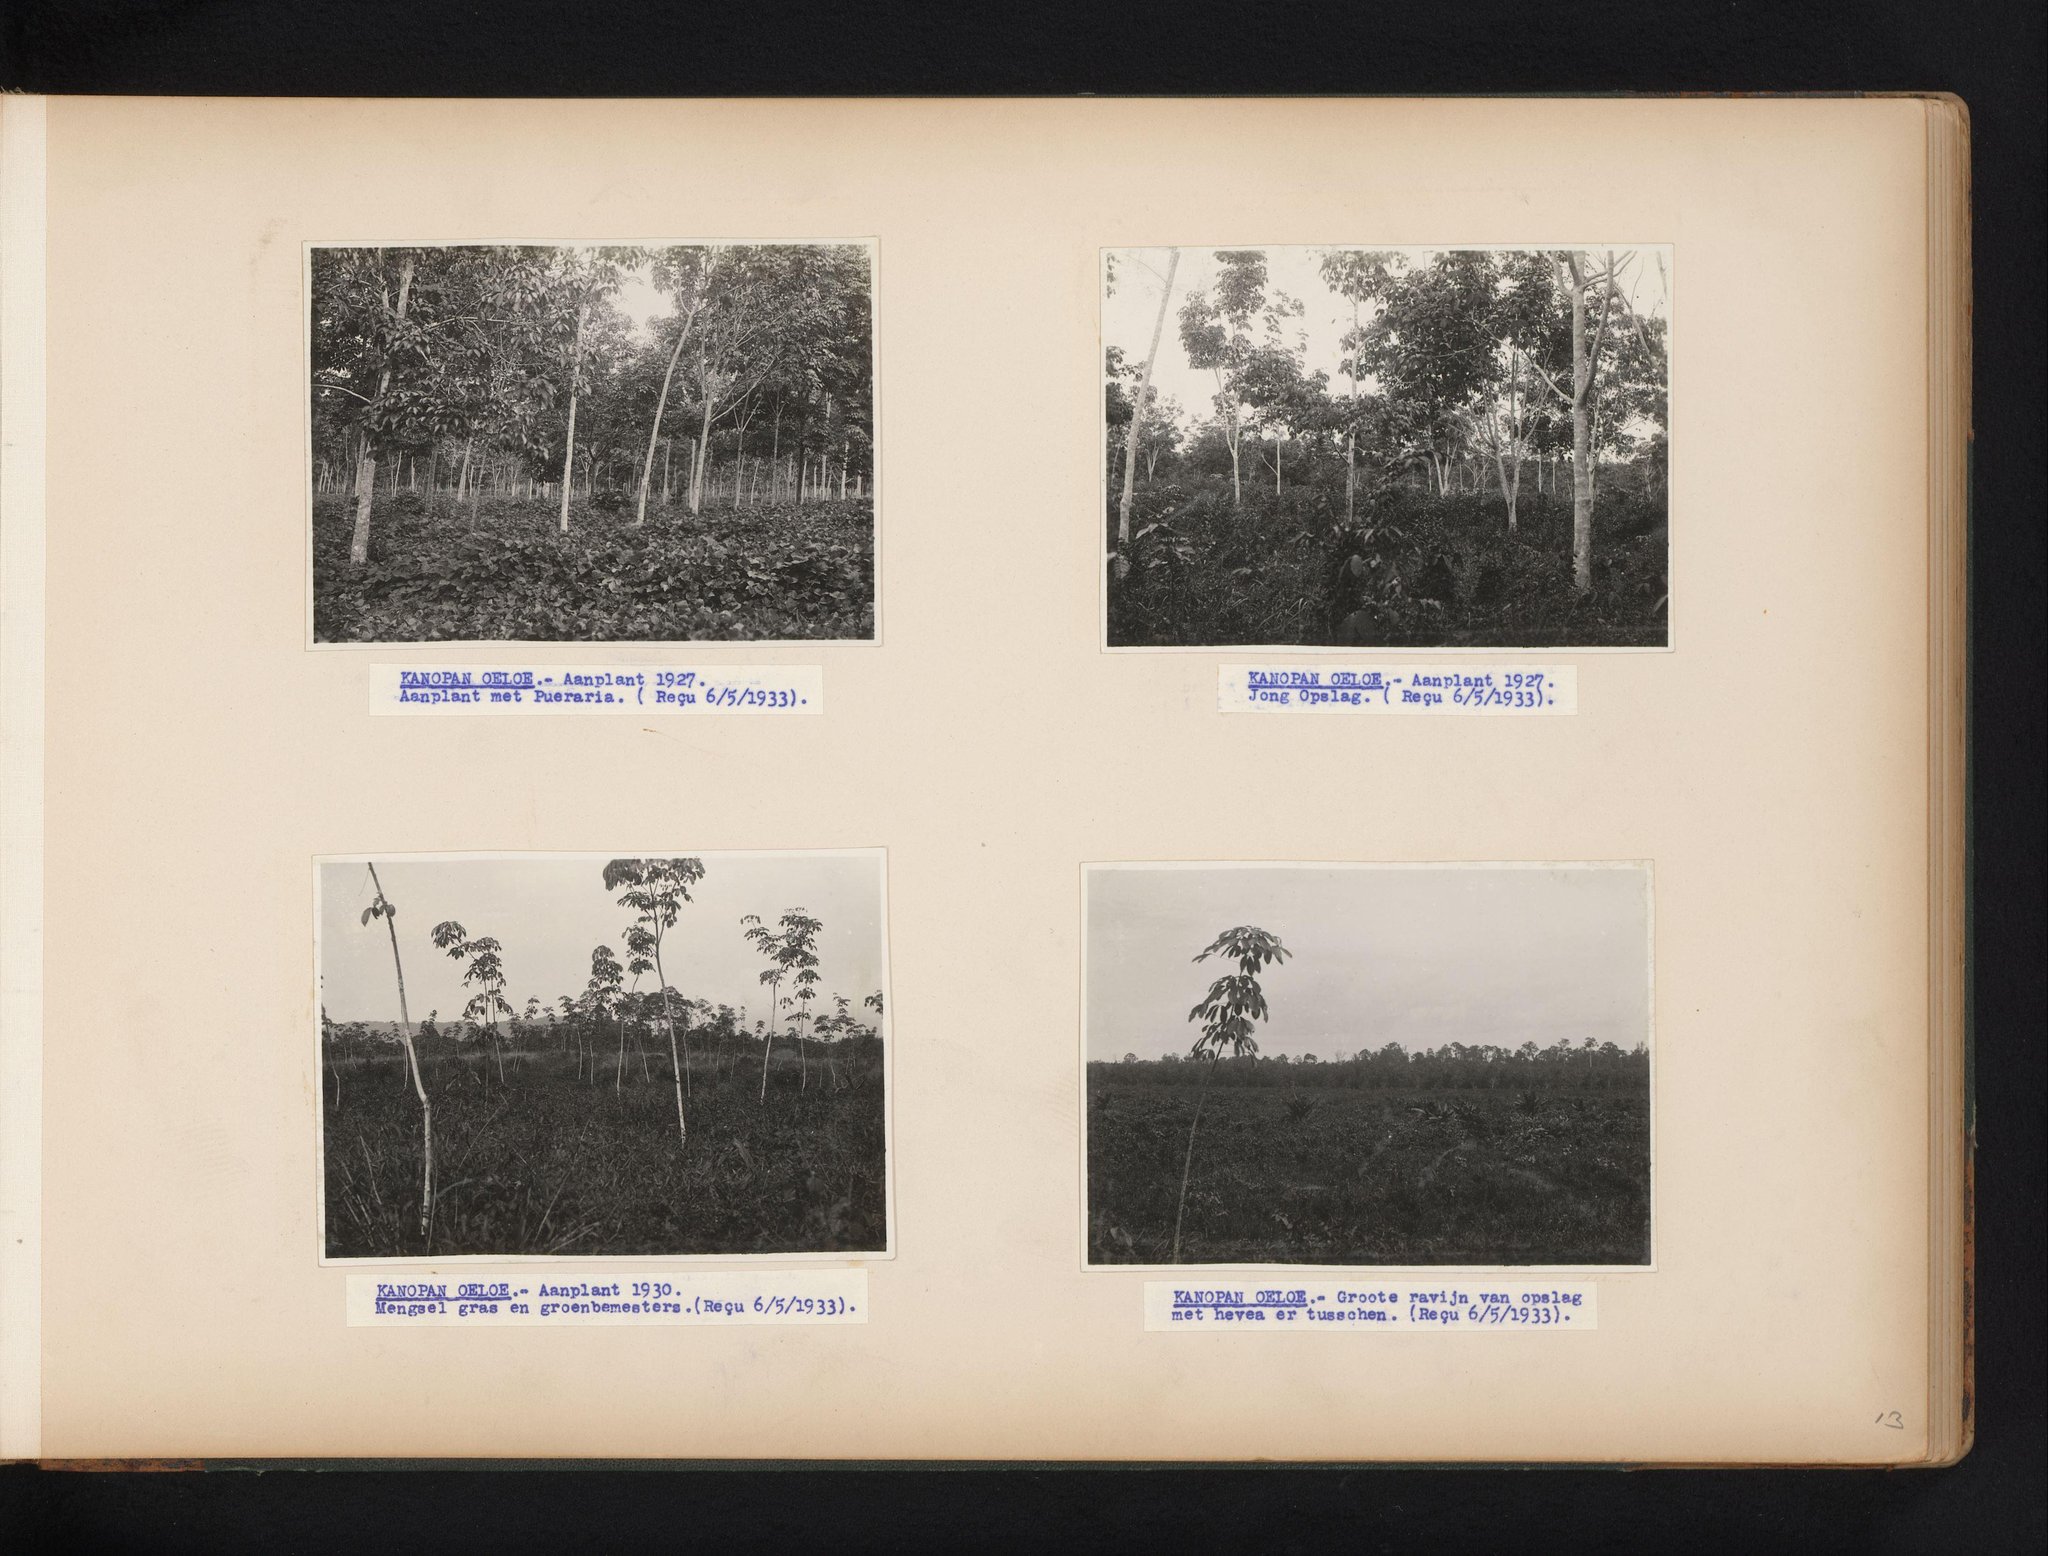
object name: photograph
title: Rubberbomen op Kanopan Oeloe, 1933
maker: Anonymous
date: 1933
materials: cardboard, photographic support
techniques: gelatin silver print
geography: sumatra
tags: plantation, (non-fruit) products of plants or trees: rubber, sumatra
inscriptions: inscription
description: Blad met vier foto's van rubberbomen op de plantage Kanopan Oeloe, 1933. Onderdeel van het fotoalbum over de plantages Leidong West en Kanopan Oeloe van de Cultuur Maatschappij Leidong West op Sumatra in de jaren 1925-1939.